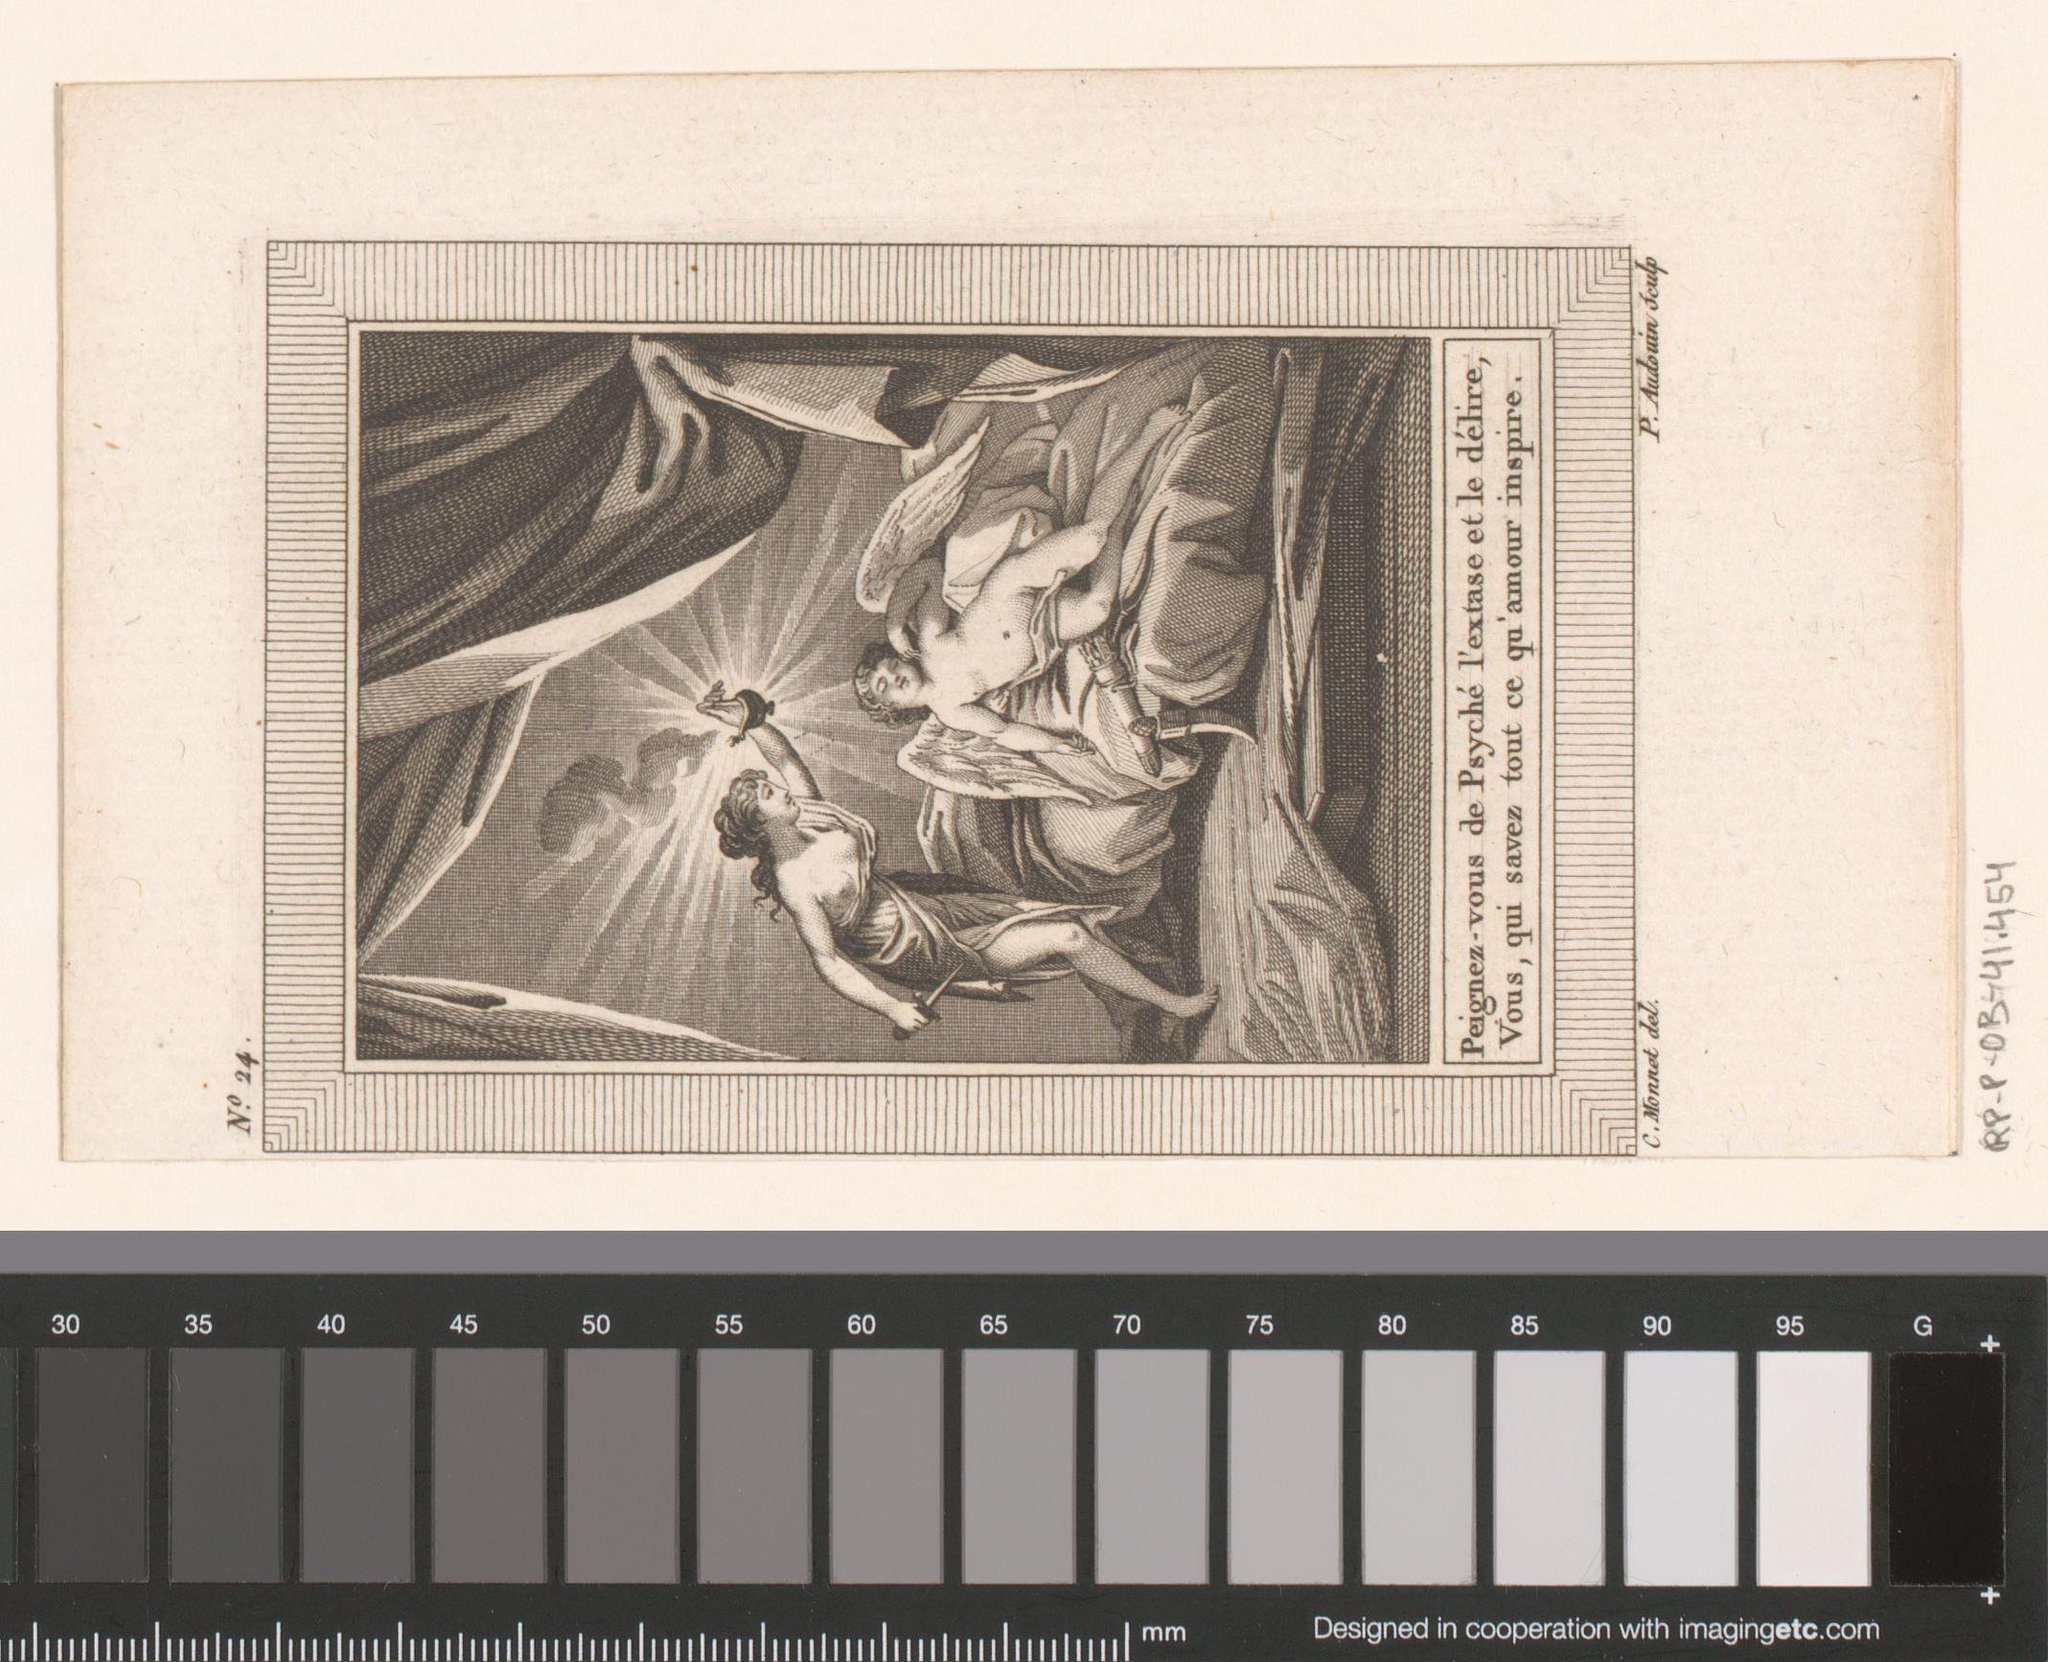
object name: print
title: Psyche wordt verliefd op Cupido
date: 1801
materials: paper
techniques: engraving, etching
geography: paris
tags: story of cupid and psyche (apuleius, 'metamorphoses' (golden ass) iv 28 - vi 25)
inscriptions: collector's mark: Lugt 2228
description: Prent uit: C.A. Demoustier. Lettres a Émilie, sur la mythologie. Paris: A.A. Renouard, 1801.